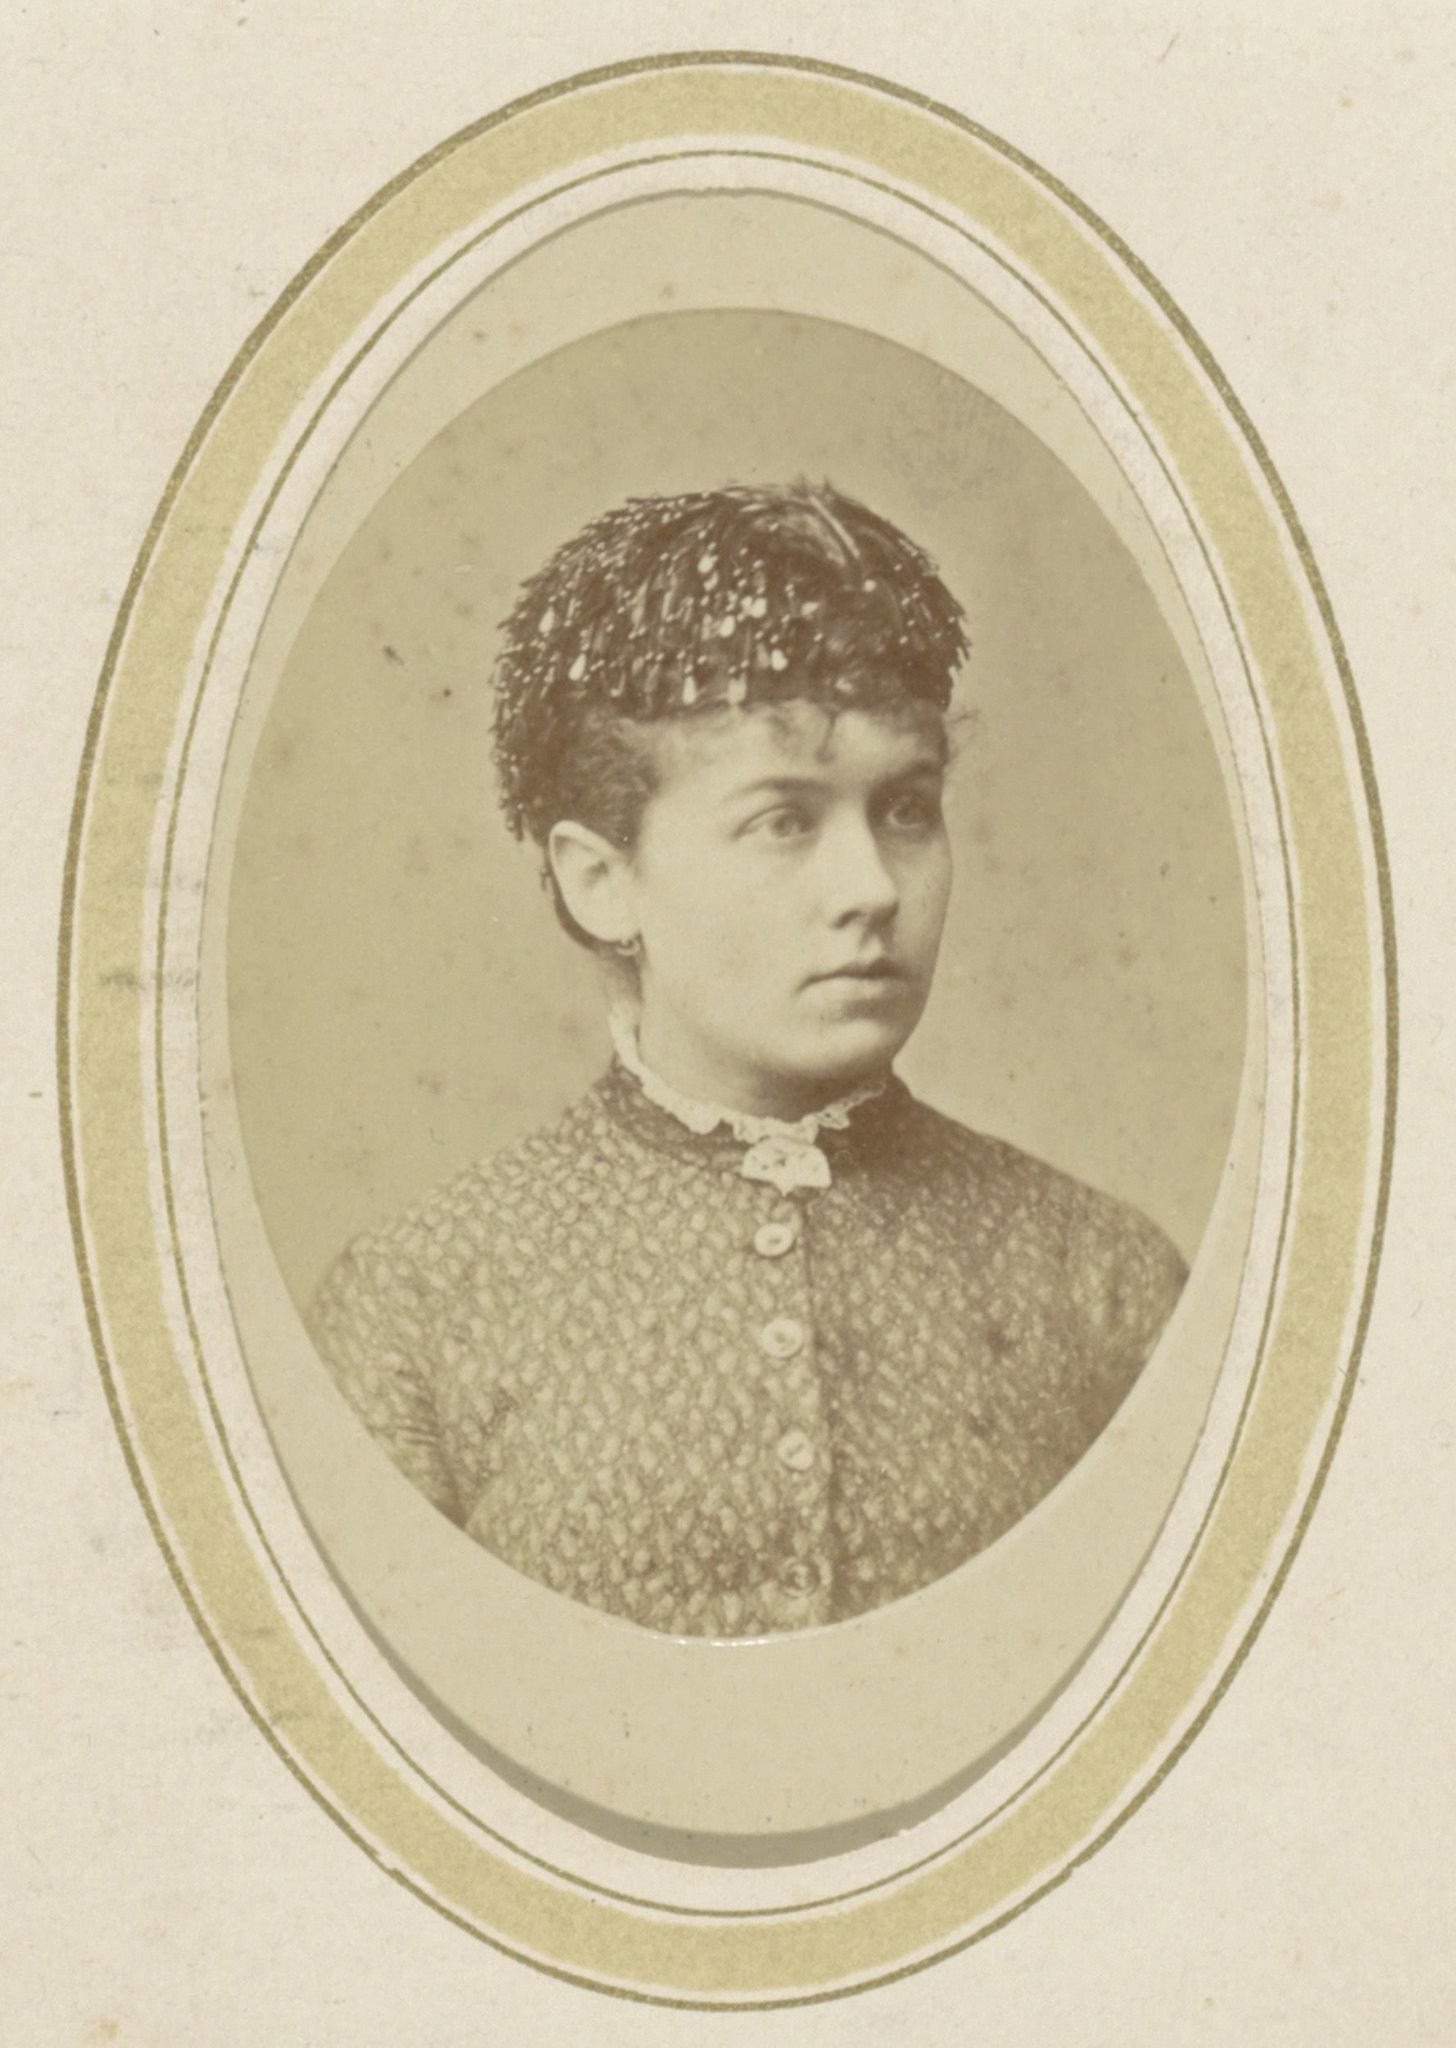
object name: photograph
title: Portret van een jonge vrouw met een hoofddeksel met kralen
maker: abraham koorenhoff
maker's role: fotograaf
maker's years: 1844-1917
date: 1863-1900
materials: cardboard, paper, photographic support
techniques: albumen print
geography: leiden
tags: head-gear, historical persons, neck-gear ~ clothing, clothing for the upper part of the body, leiden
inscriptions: address: ‘Leiden’, address: ‘Gerecht No. 5 bij de Pieterskerk’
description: Onderdeel van Fotoalbum van een Nederlandse familie met 168 cartes-de-visite en kabinetfoto's.